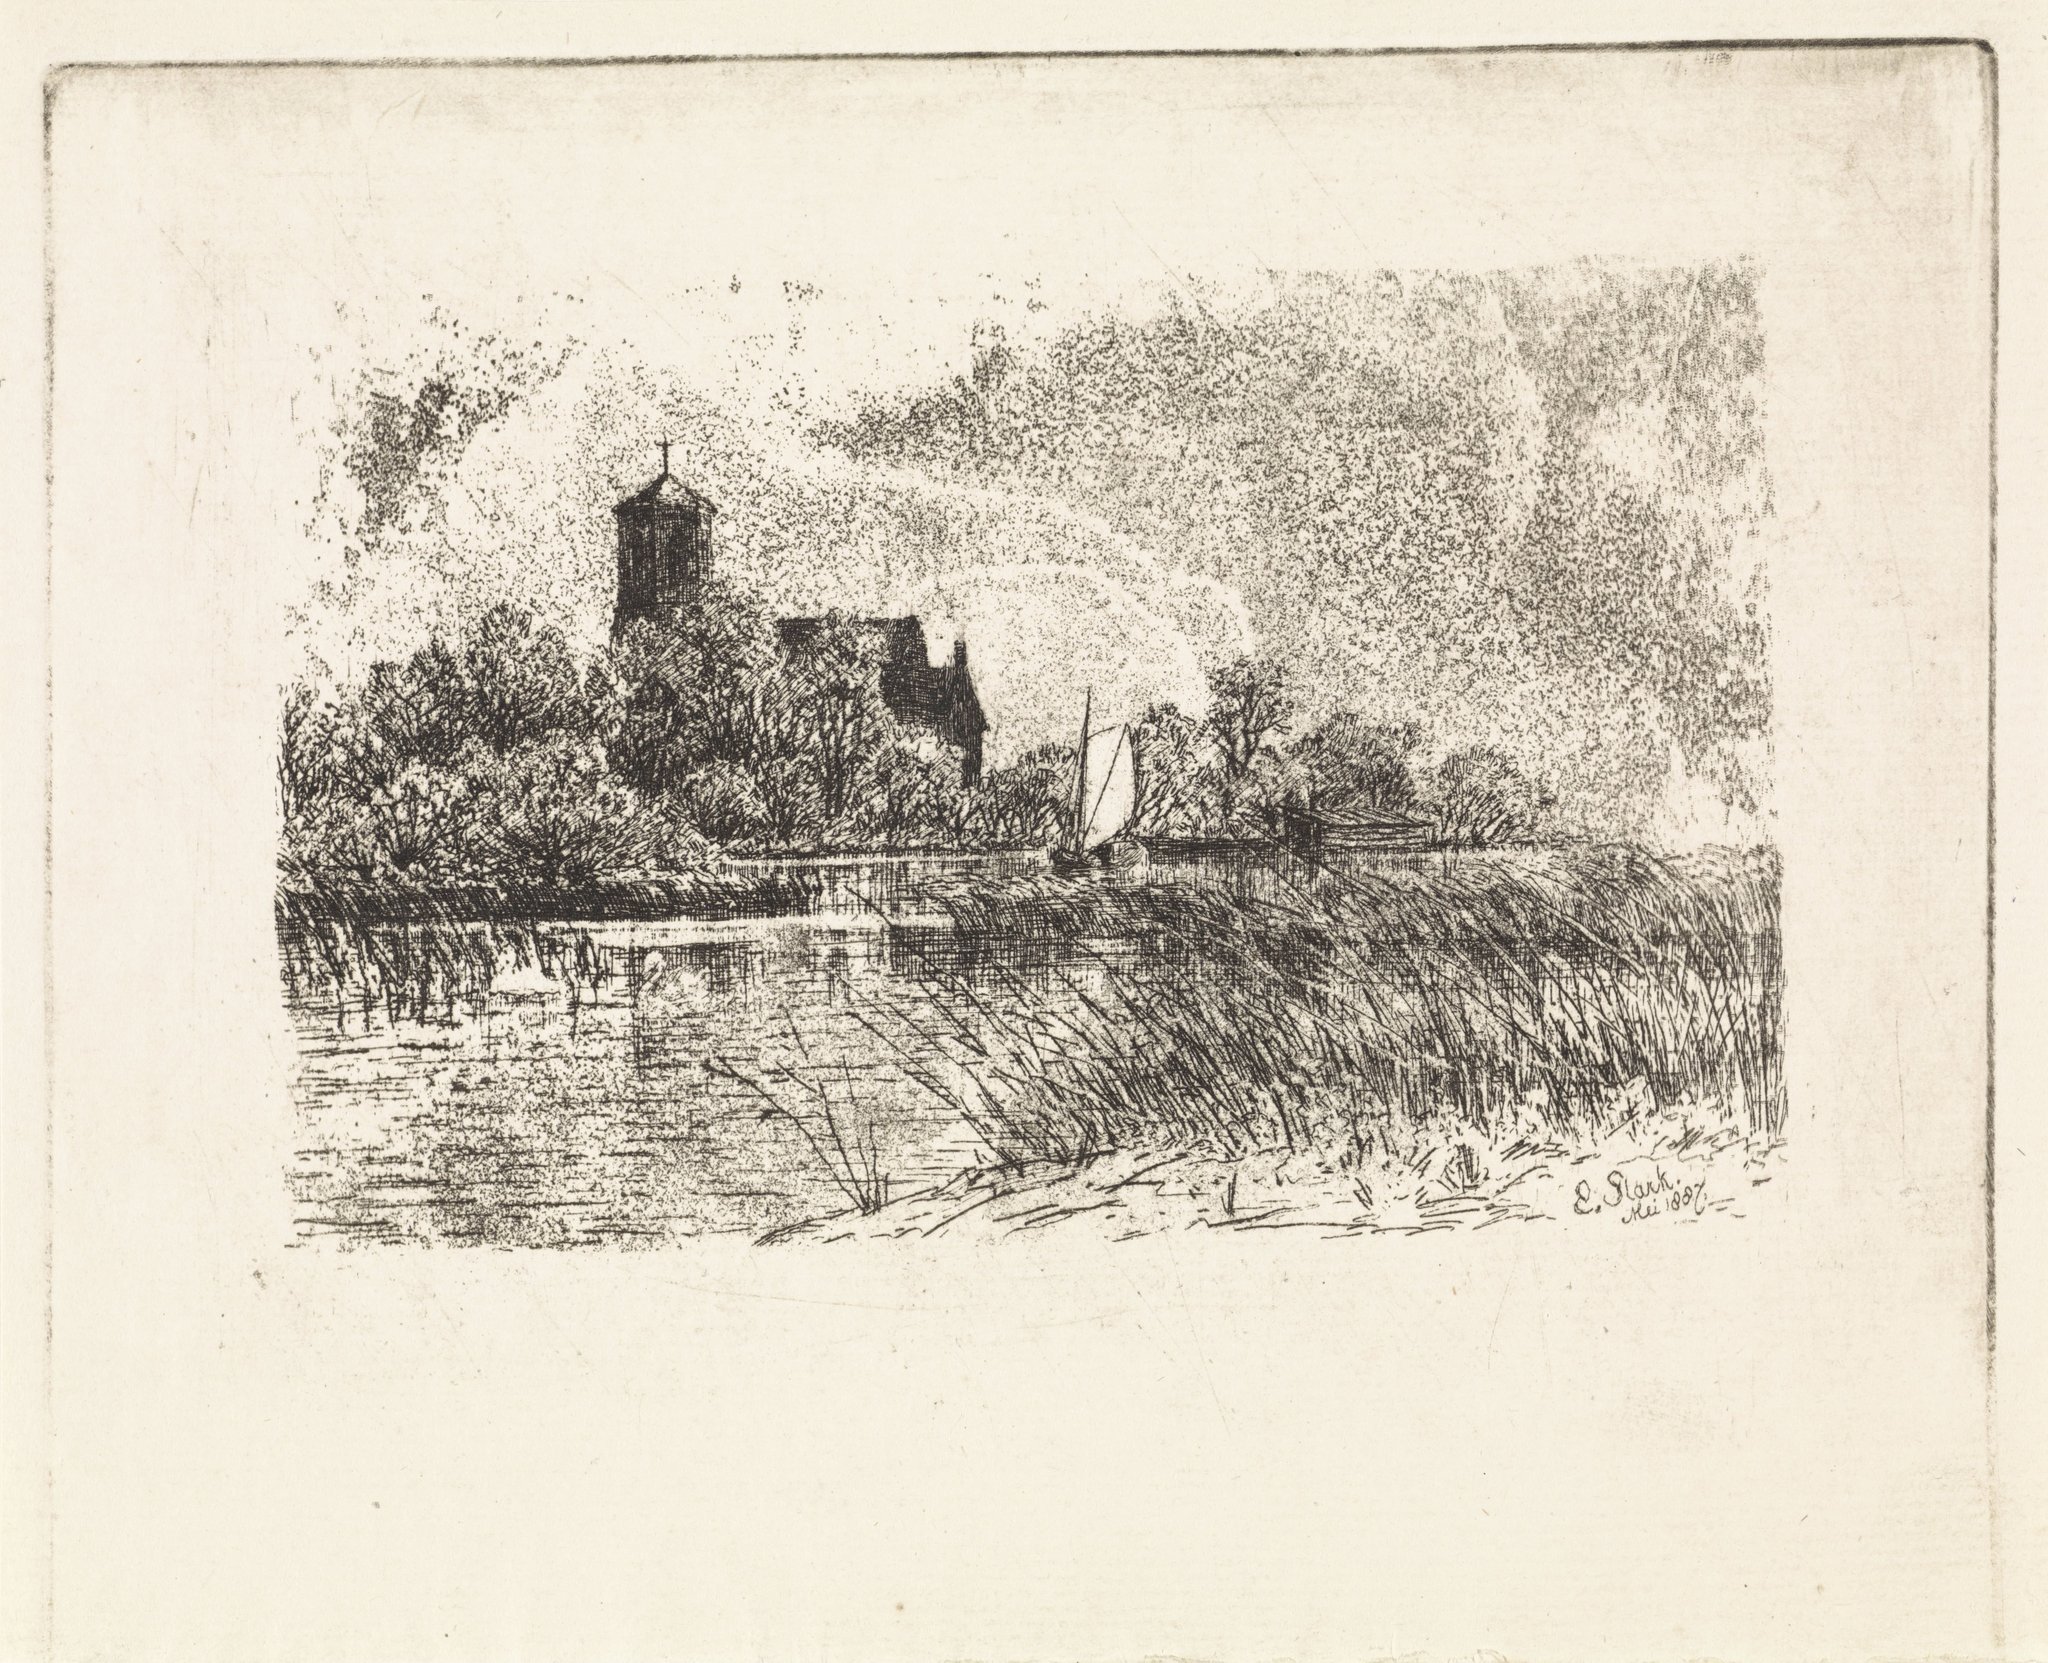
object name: print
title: Gezicht op de Sint Urbanuskerk te Bovenkerk met op het water een zeilscheepje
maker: elias stark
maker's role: draughtsman, print maker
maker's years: 1849-1933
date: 1805-1887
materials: paper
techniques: aquatint, etching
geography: nieuwer-amstel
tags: church (exterior)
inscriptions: collector's mark: Lugt 2228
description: Gezicht op de St. Urbanuskerk te Bovenkerk met op de voorgrond op het water een zeilscheepje en zwanen.